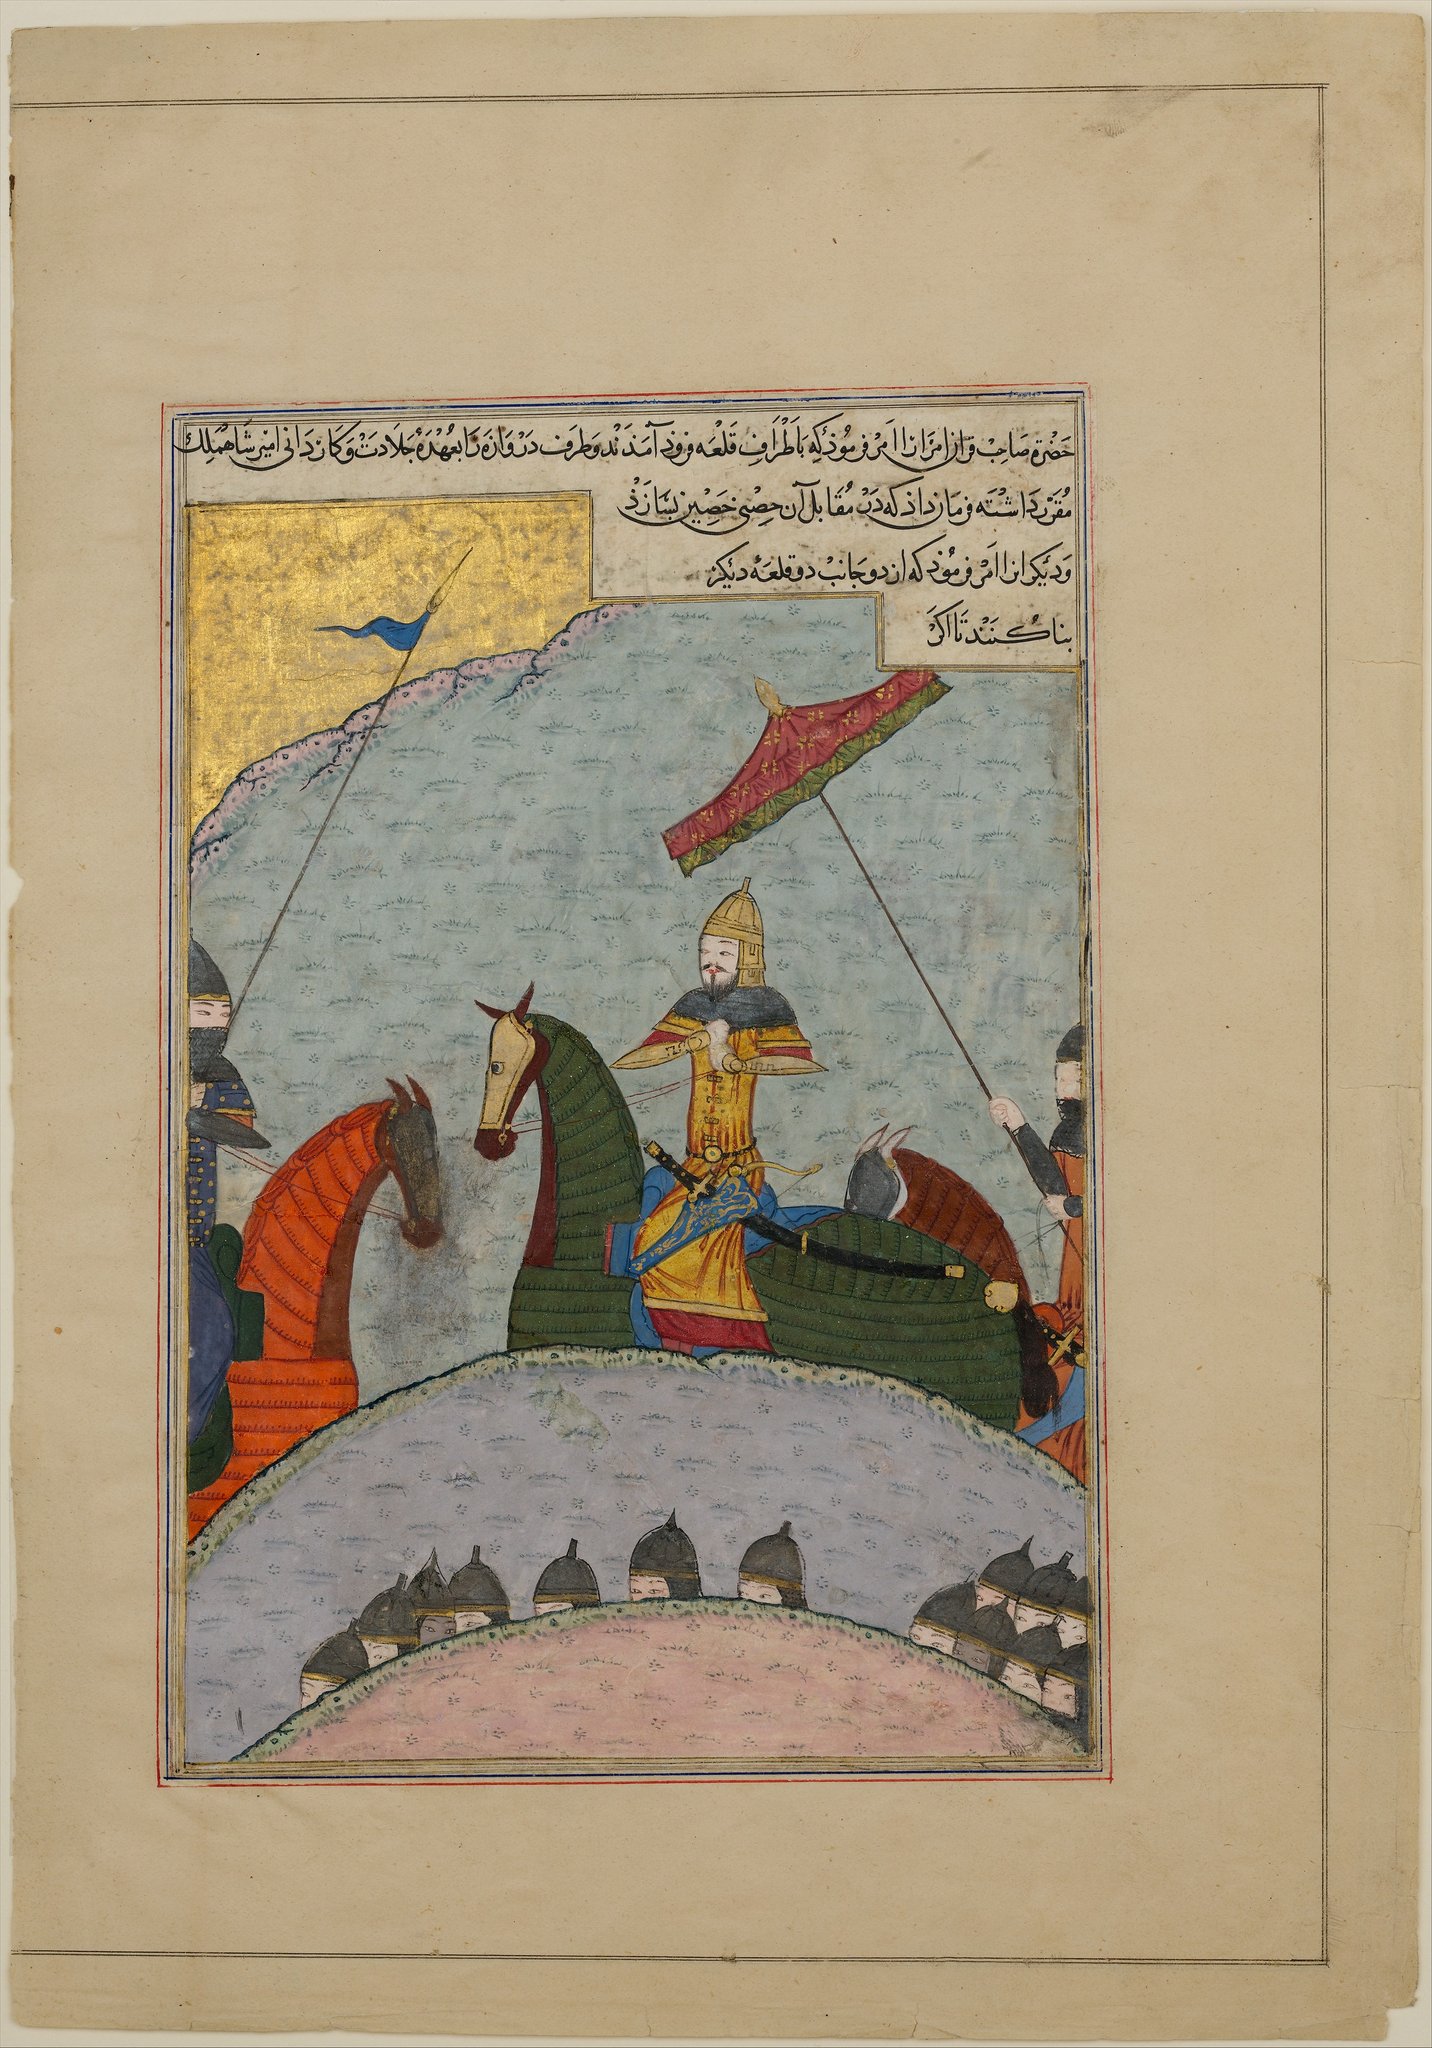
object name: folio from an illustrated manuscript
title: "Timur before Battle", Folio from a Dispersed Copy of the Zafarnama (Book of Victories) of Sharaf al-din 'Ali Yazdi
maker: sharaf al-din 'ali yazdi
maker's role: author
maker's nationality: iranian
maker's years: 1370-1454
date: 839-1436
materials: gold, ink, paper, silver, watercolor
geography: iran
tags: soldiers,men,horses